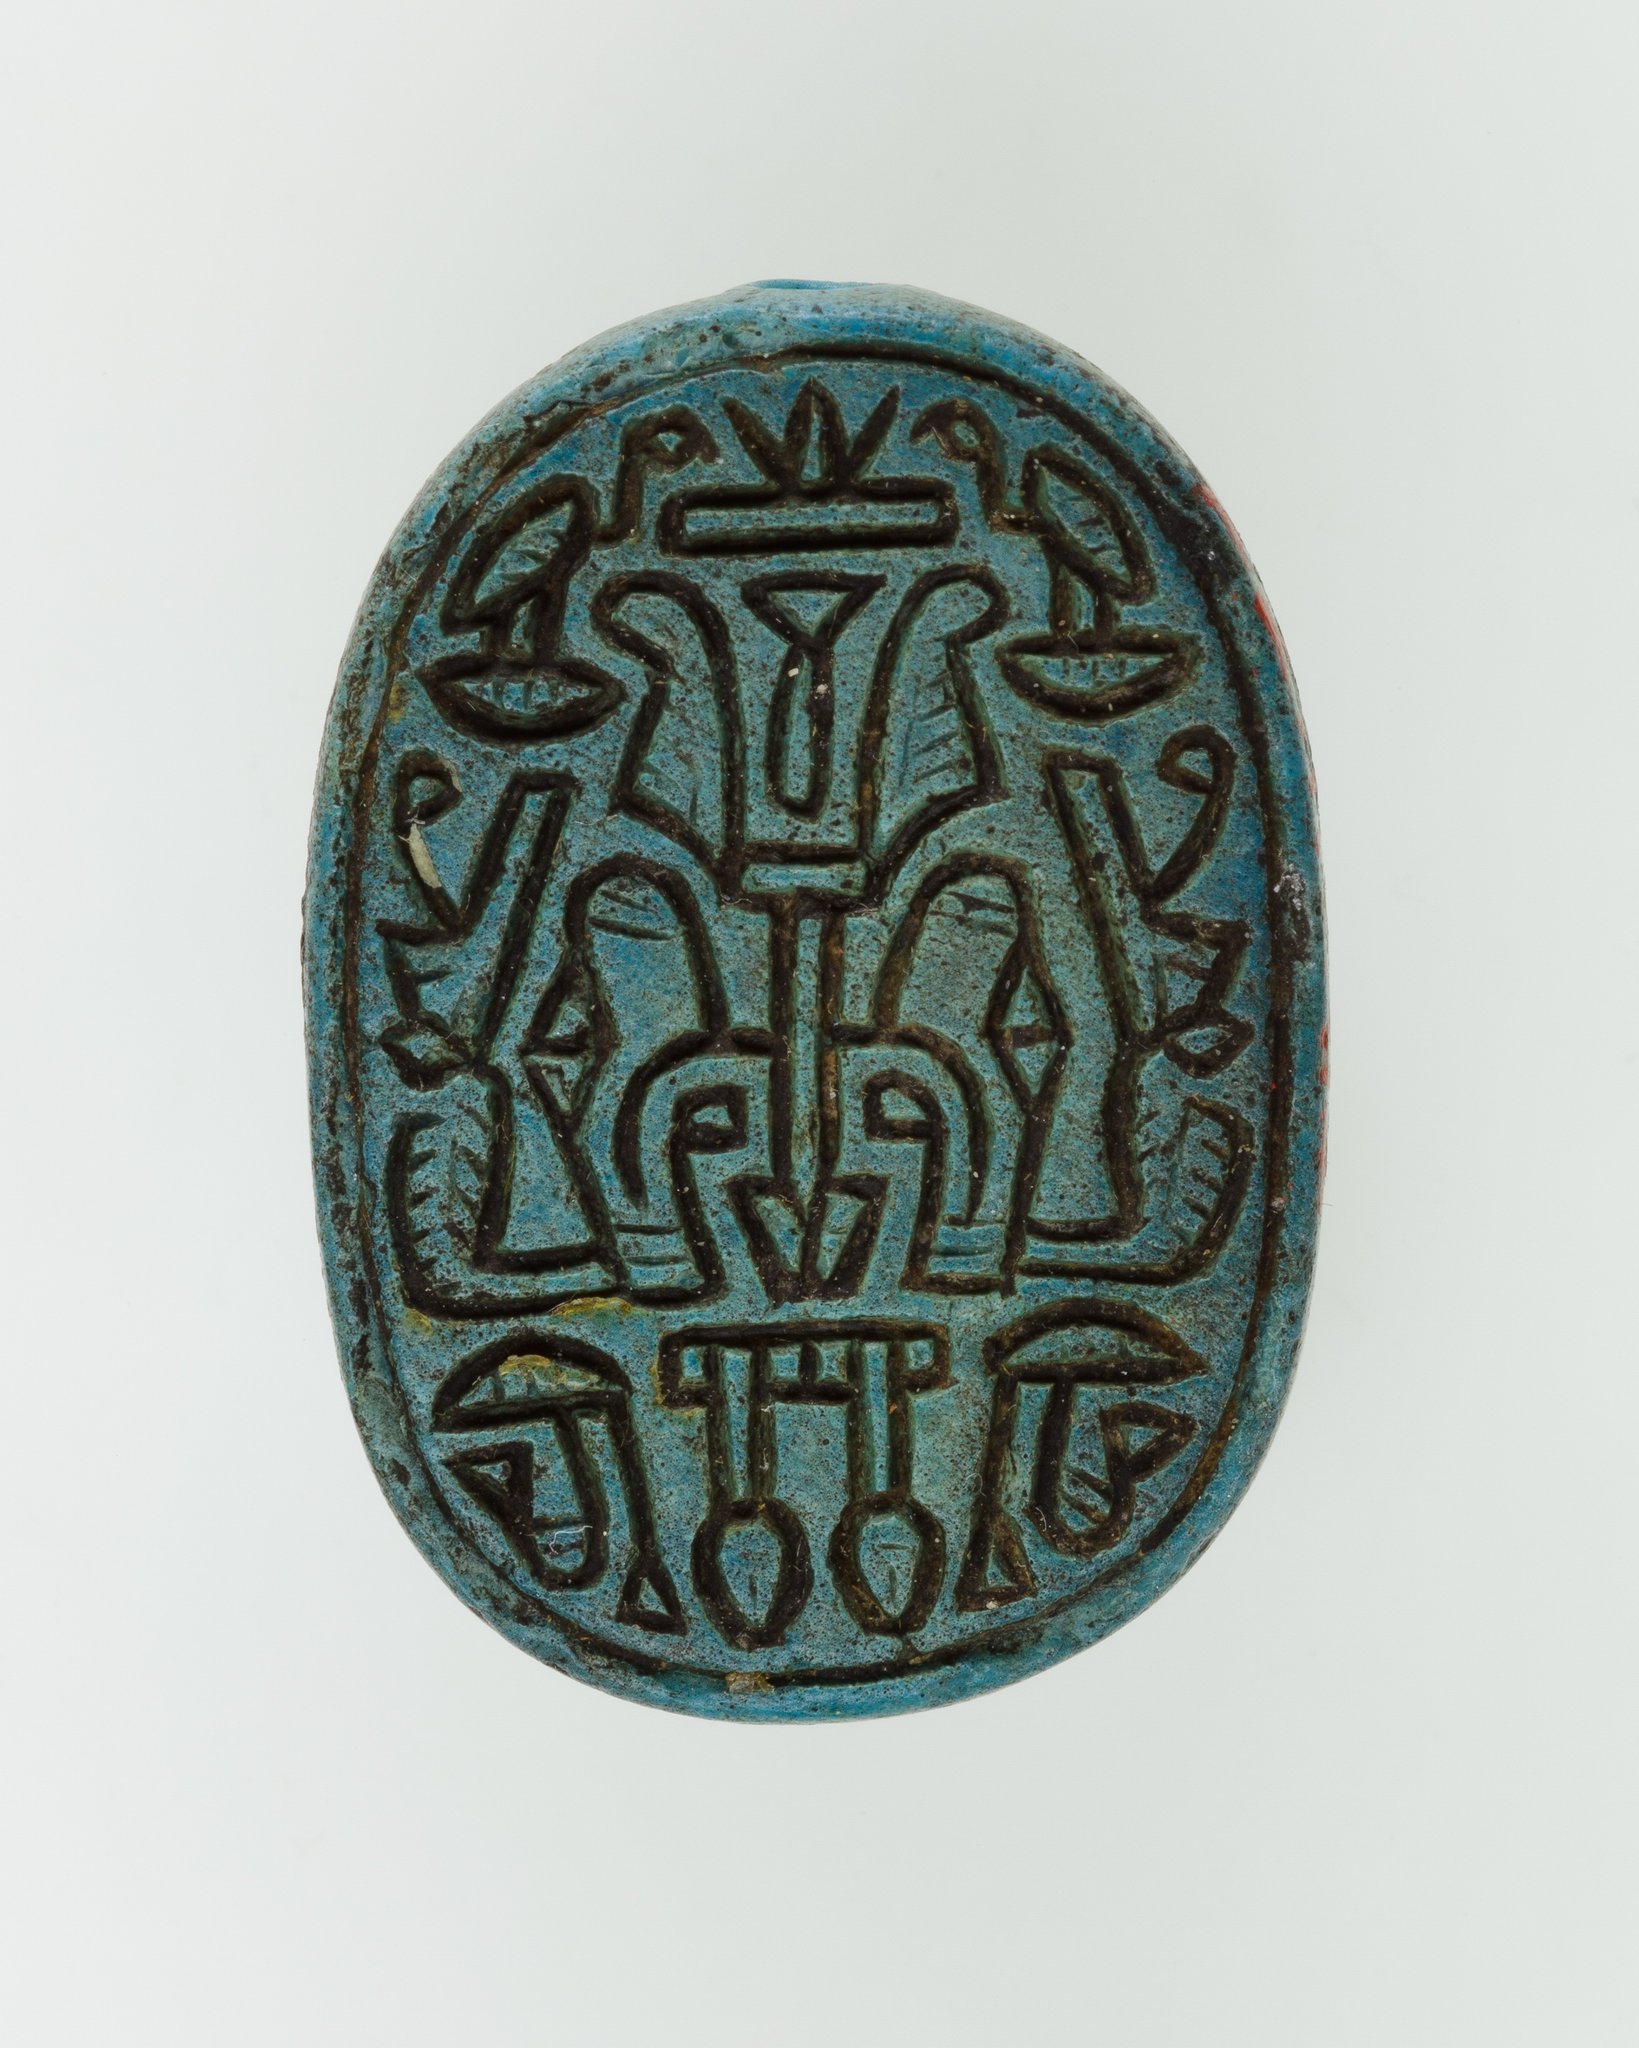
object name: scarab, hieroglyph, sema tawy, crowned uraei, nefer, wadj, vulture, papyrus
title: Scarab Inscribed with Hieroglyphs and Symbols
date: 1850-1640 BCE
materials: stone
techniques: glazing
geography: egypt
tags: hieroglyphs,scarabs